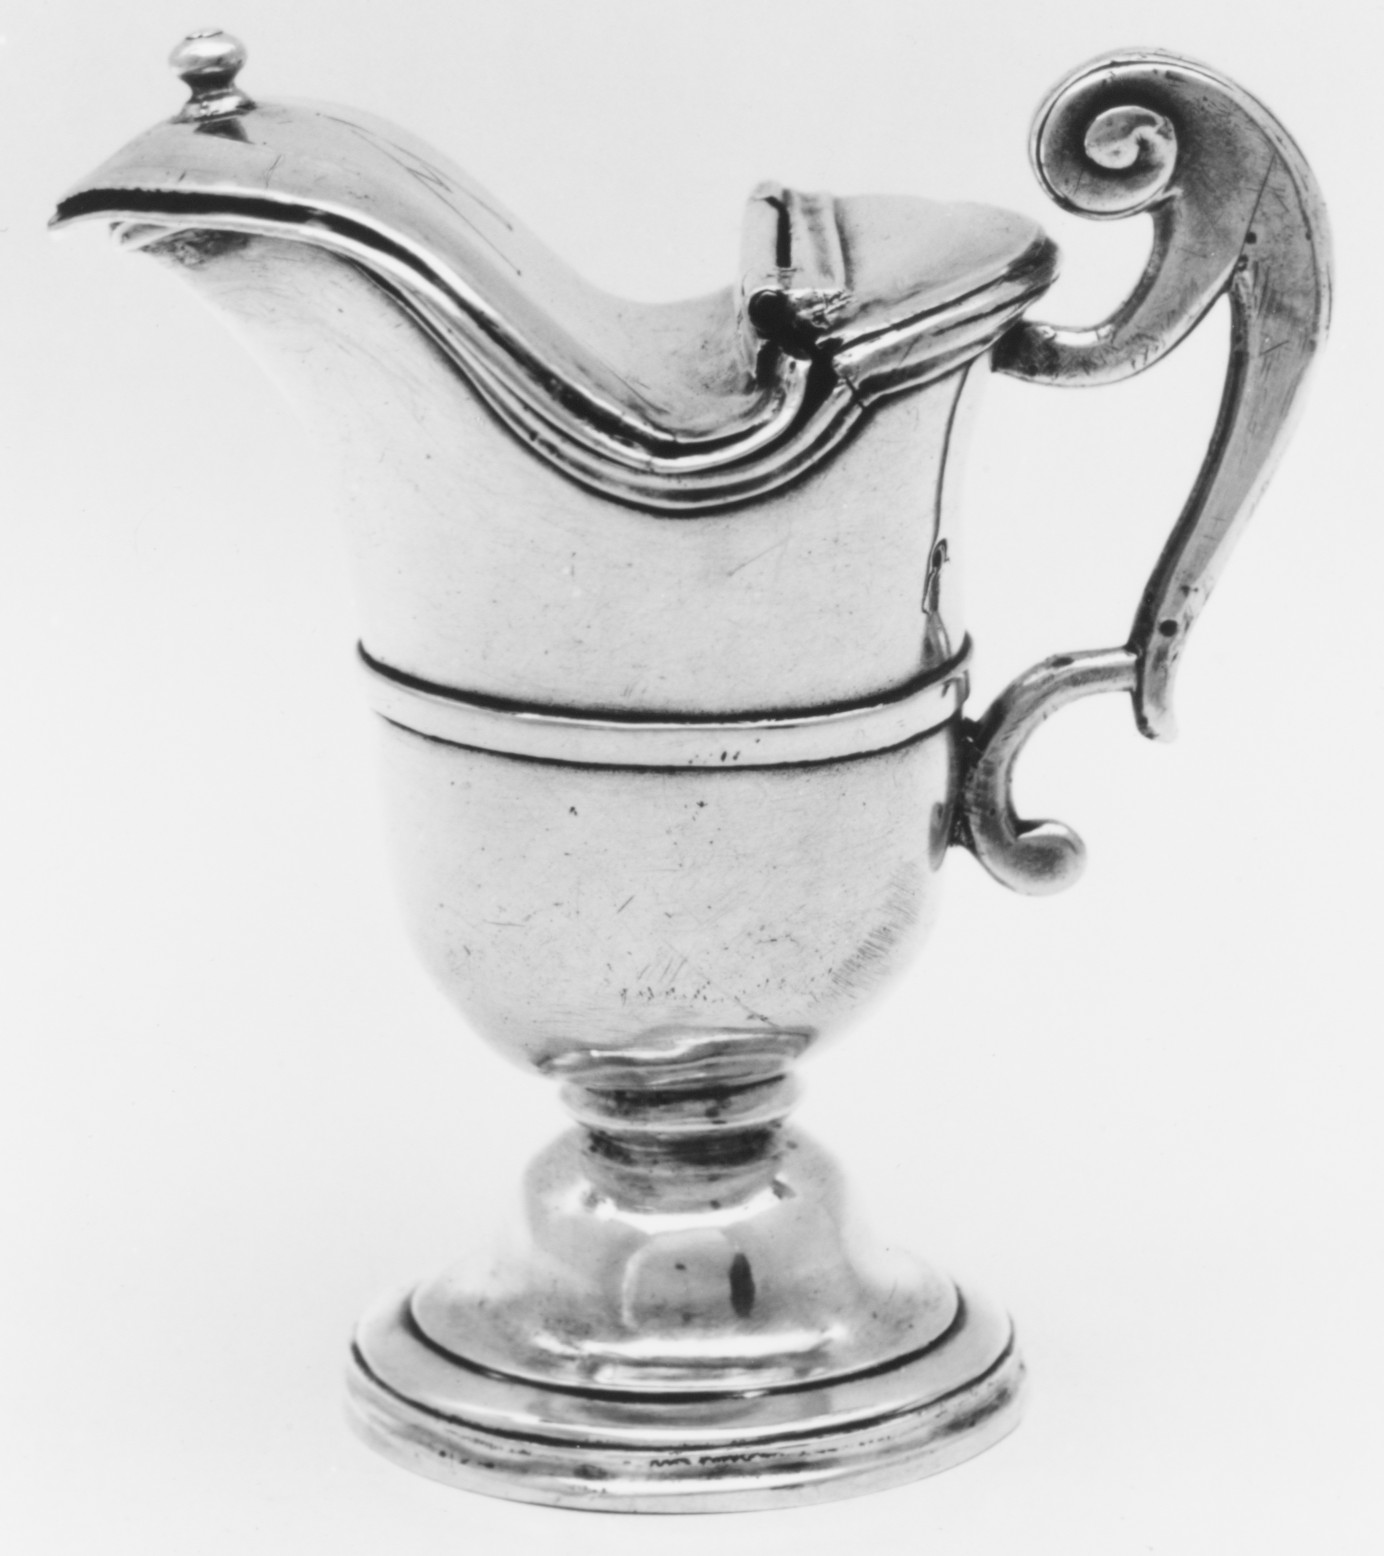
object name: altar cruet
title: Altar cruet (one of a pair)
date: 1701-1750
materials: silver